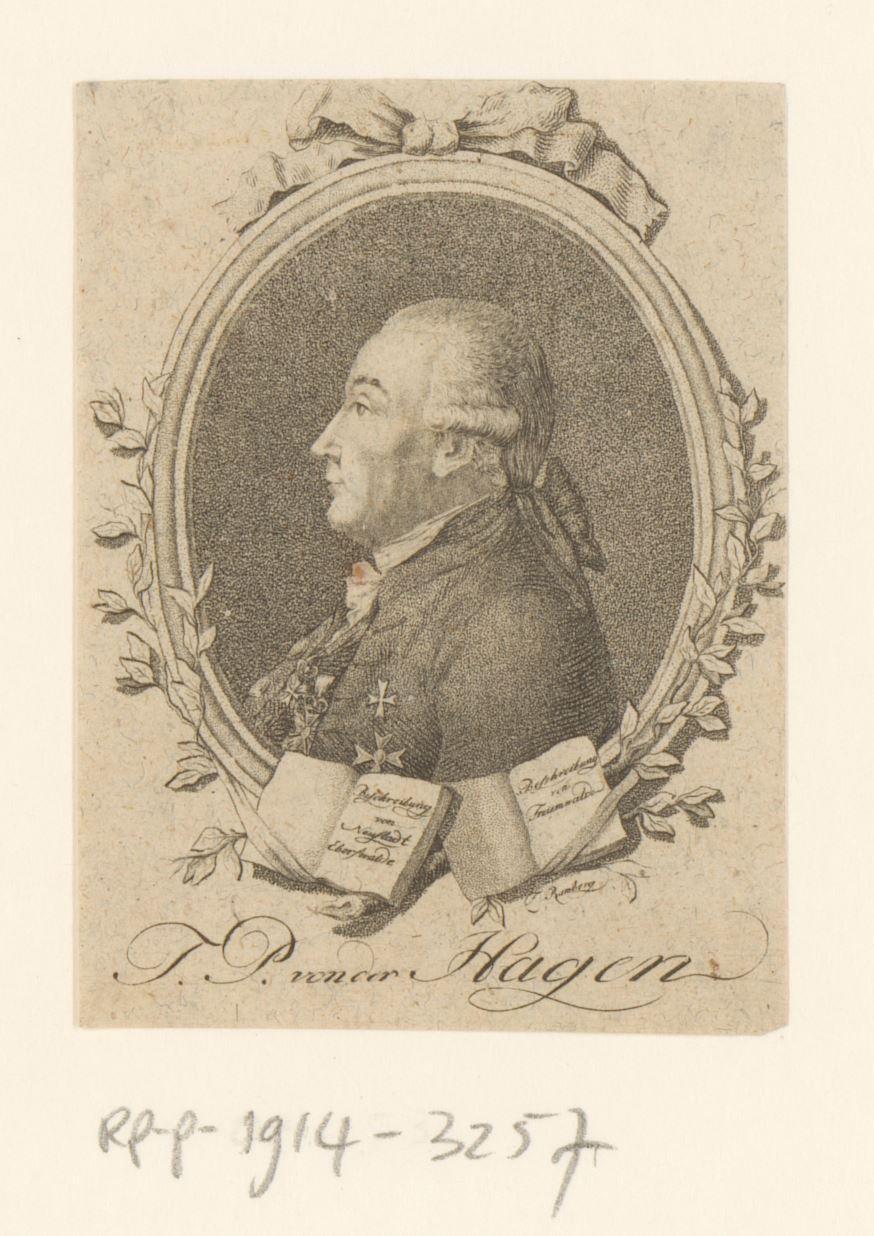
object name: print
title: Portret van Thomas Philipp von der Hagen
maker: f. ramberg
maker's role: print maker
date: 1775-1825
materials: paper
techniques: engraving, etching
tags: berlin, historical persons, book, medals and other marks of military honour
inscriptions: collector's mark: Lugt 2228